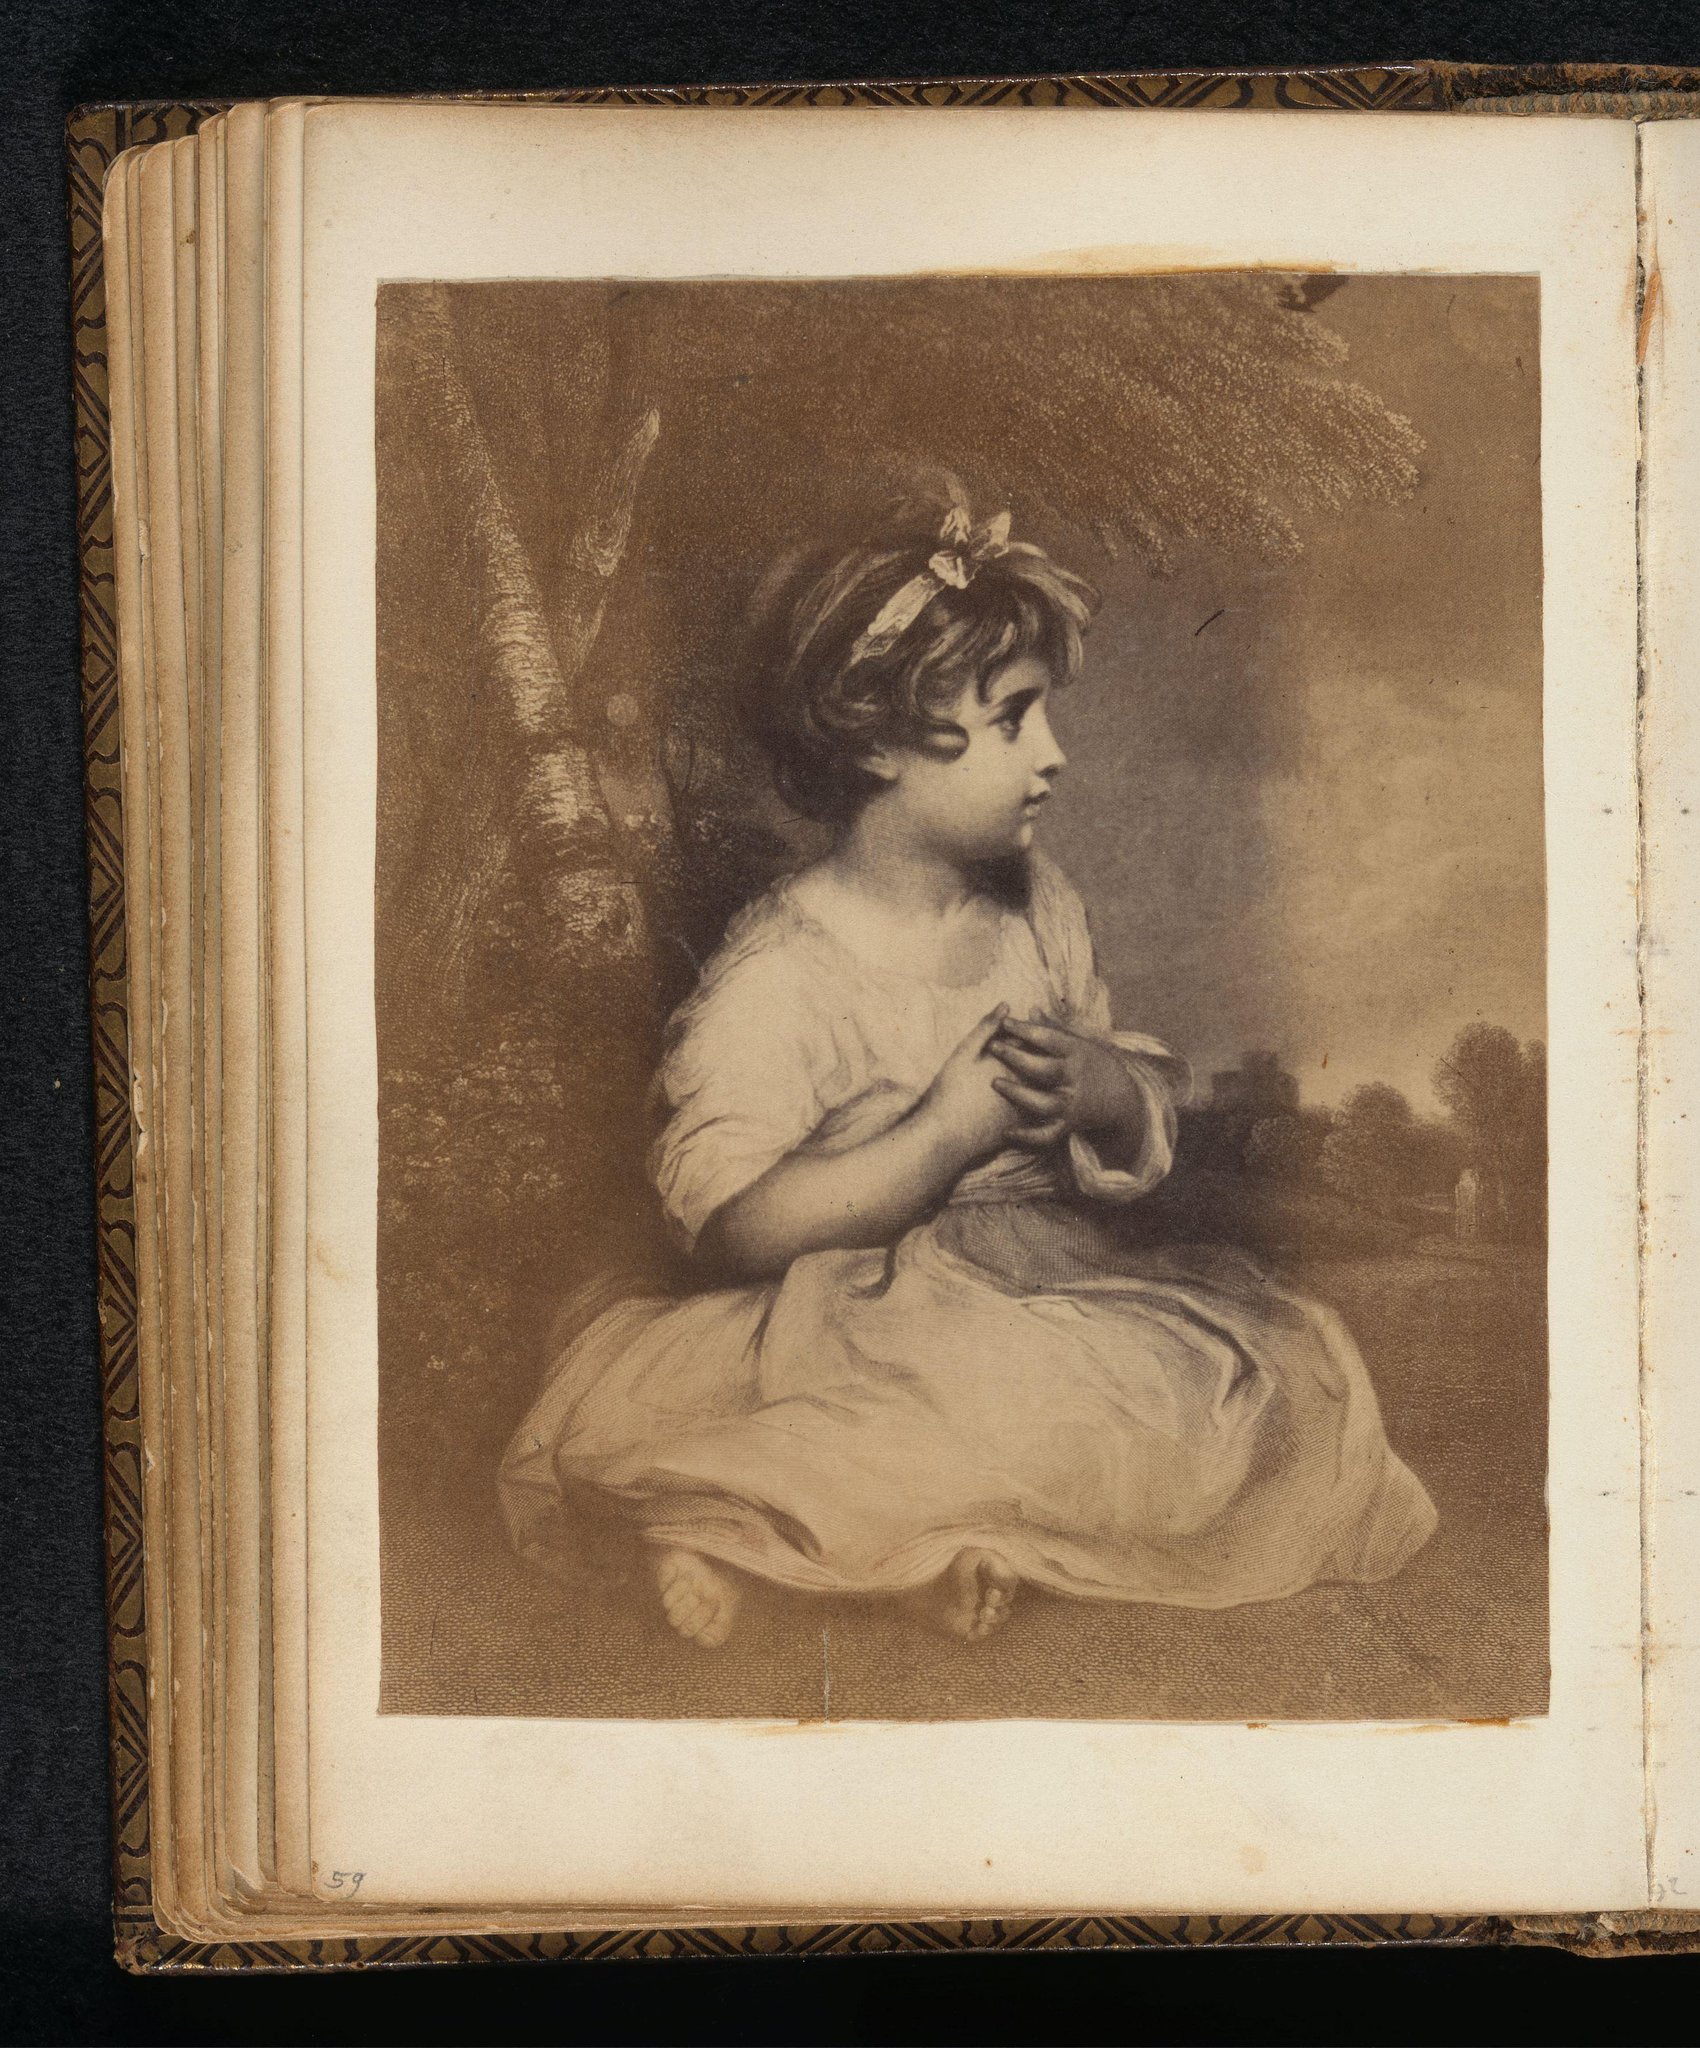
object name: album leaf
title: Schilderij van een jong meisje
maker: Anonymous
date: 1865-1867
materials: cardboard, photographic support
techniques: albumen print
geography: england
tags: girl (child between toddler and youth), picture, painting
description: Schilderij van een jong meisje, zittend op de grond aan de voet van een boom. Foto op albumblad in album met 68 foto's merendeels met geaquarelleerde randversieringen. Het zijn voornamelijk portretten op carte-de-visite formaat.